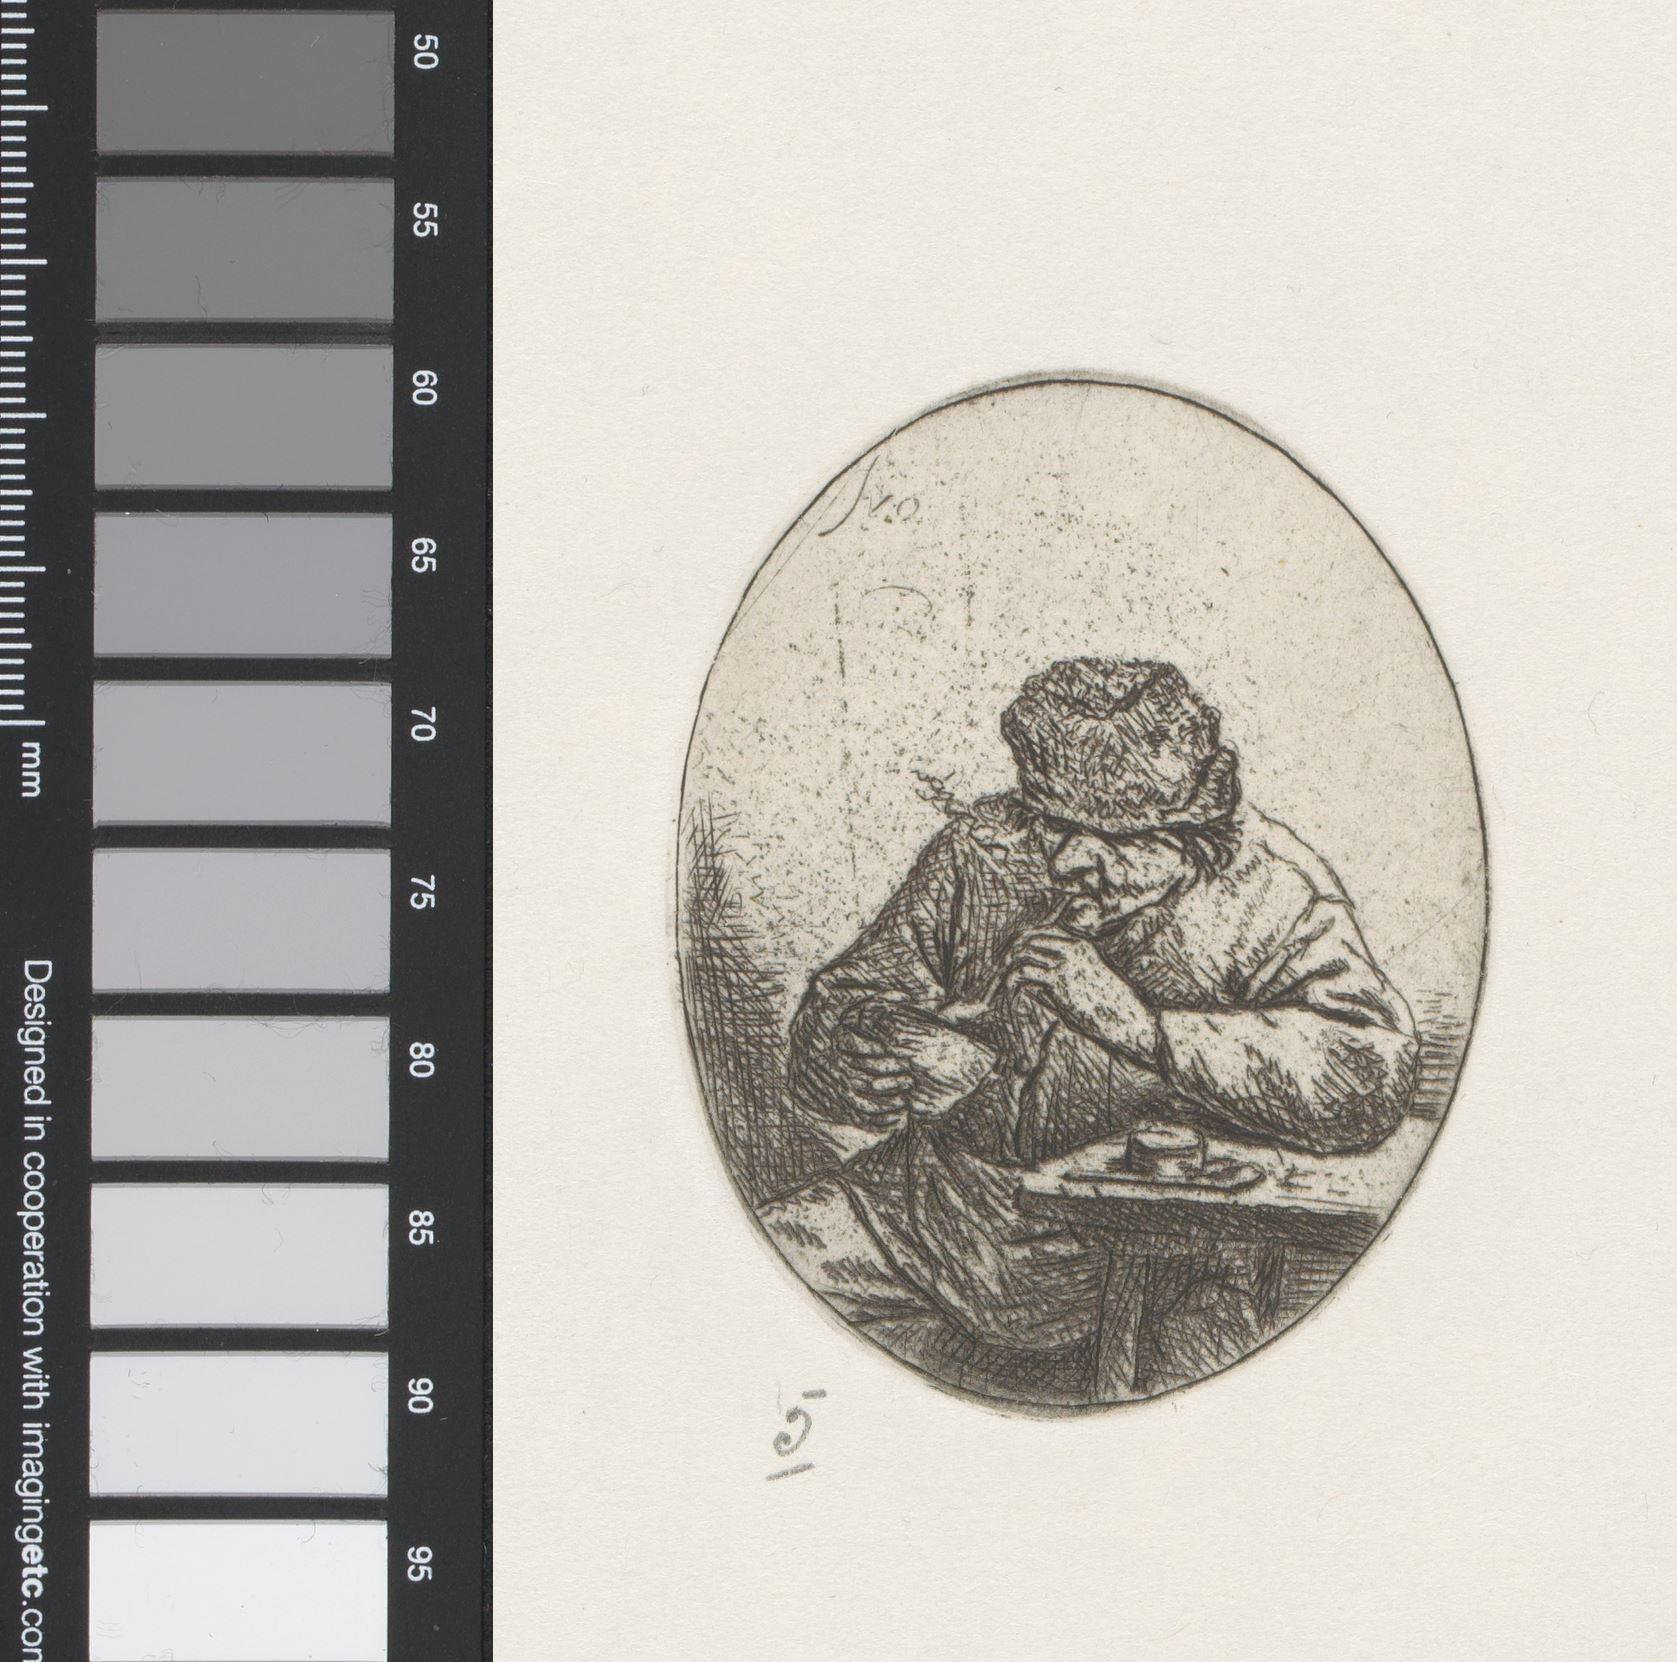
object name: album leaf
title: Man steekt zijn pijp aan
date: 1640-1647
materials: paper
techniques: etching, galvanization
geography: haarlem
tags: pipe ~ tobacco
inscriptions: collector's mark: ‘B’, collector's mark: ‘RIJKS / MUSM’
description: De prent maakt deel uit van een portefeuille en is met drie andere prenten op één albumblad gedrukt.